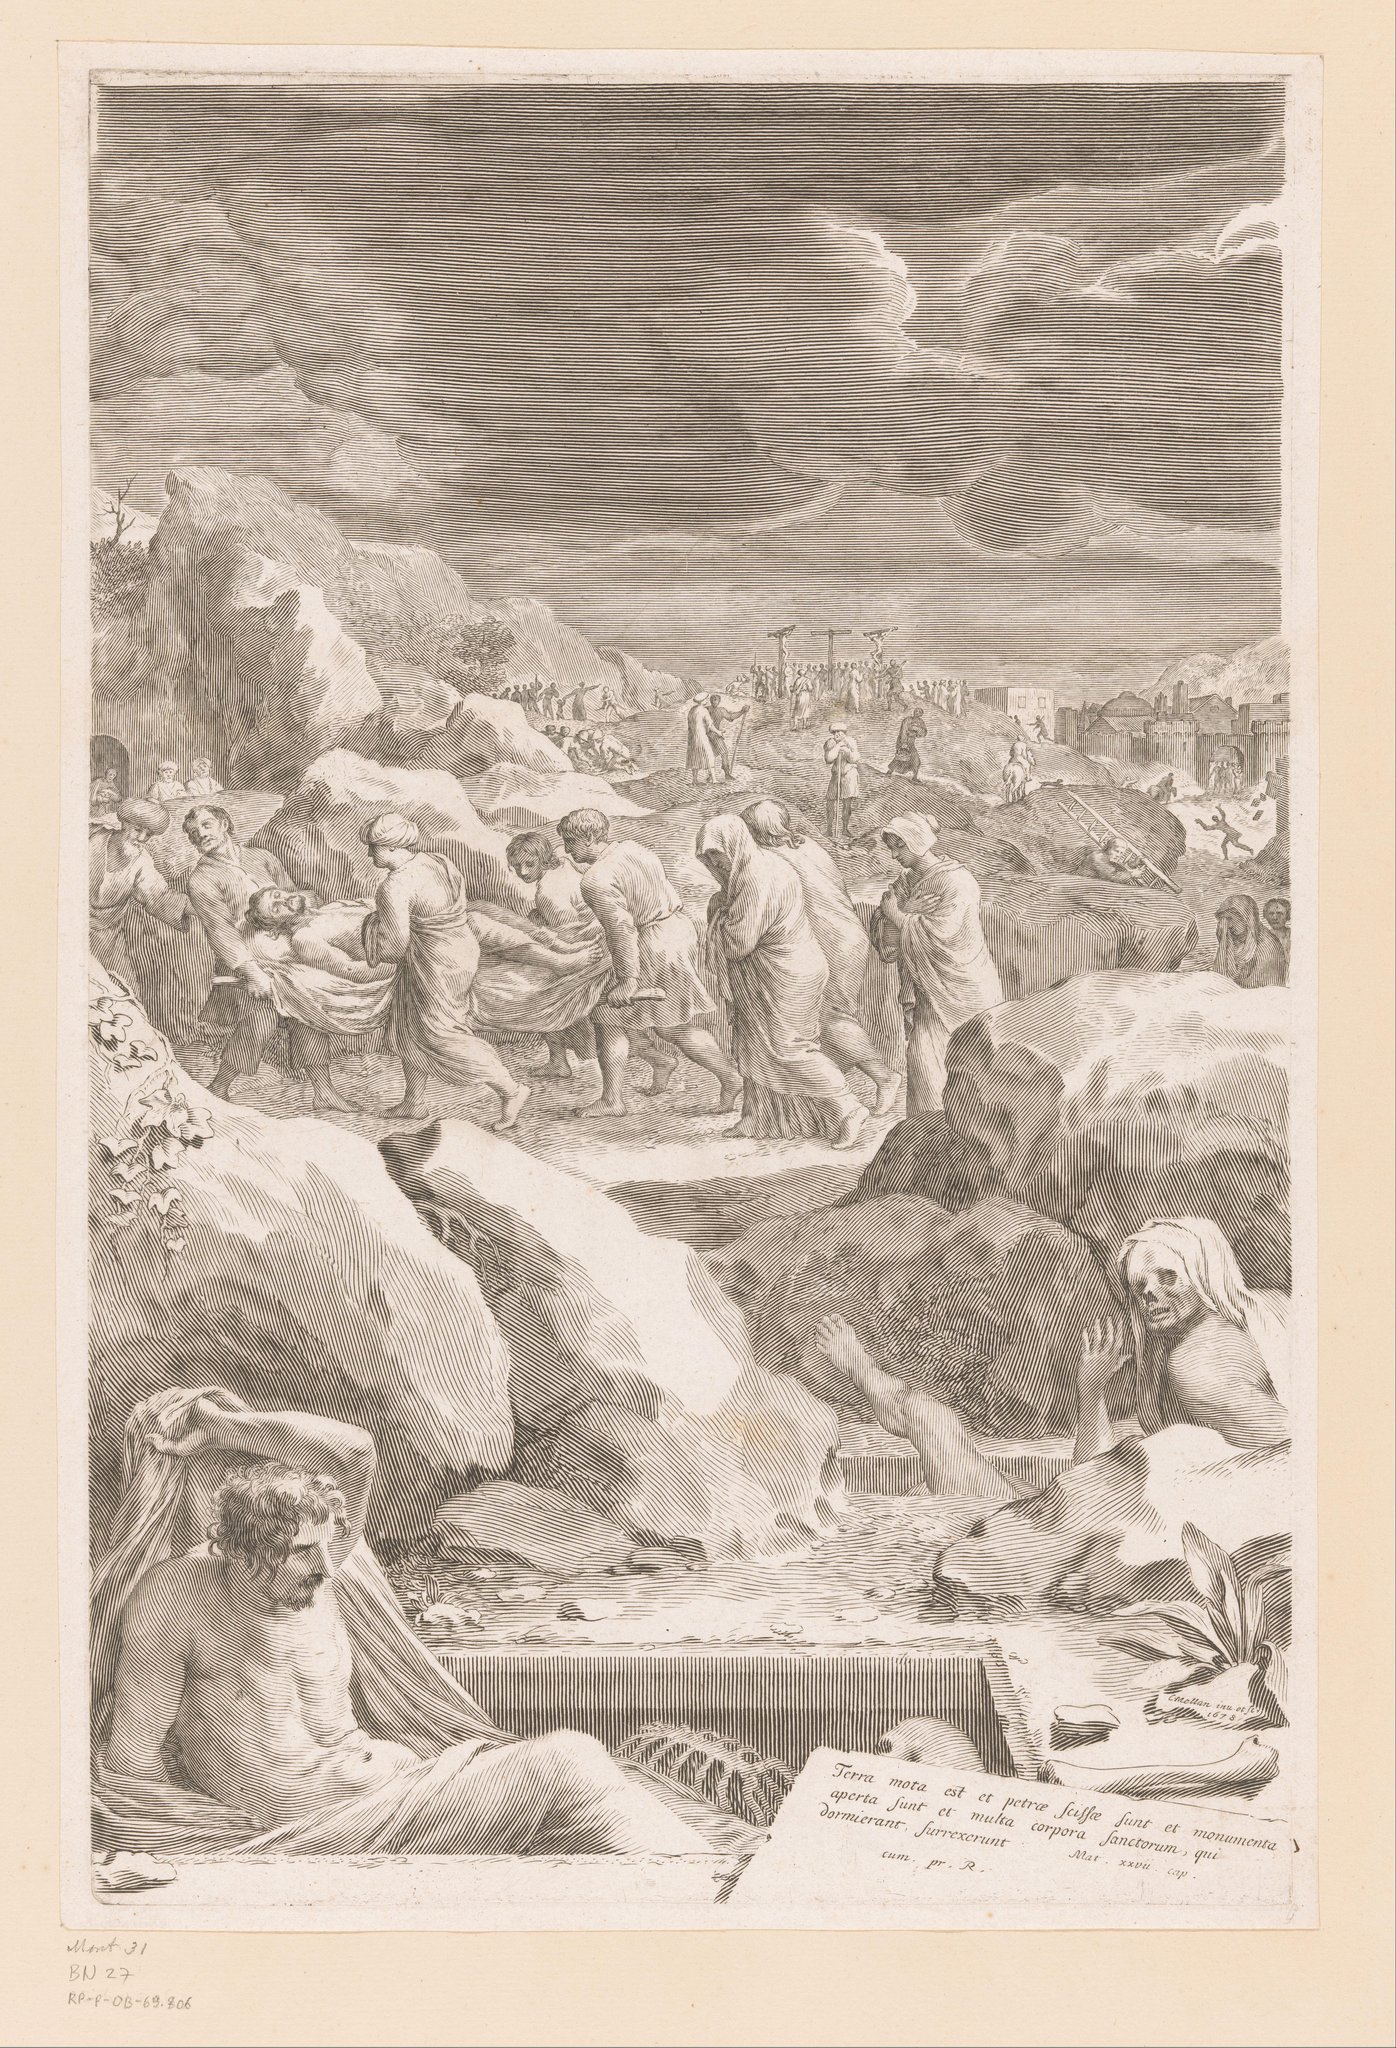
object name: print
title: Christus naar het graf gedragen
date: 1678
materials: paper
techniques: engraving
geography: france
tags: bearing of christ's body to the grave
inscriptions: collector's mark: Lugt 240